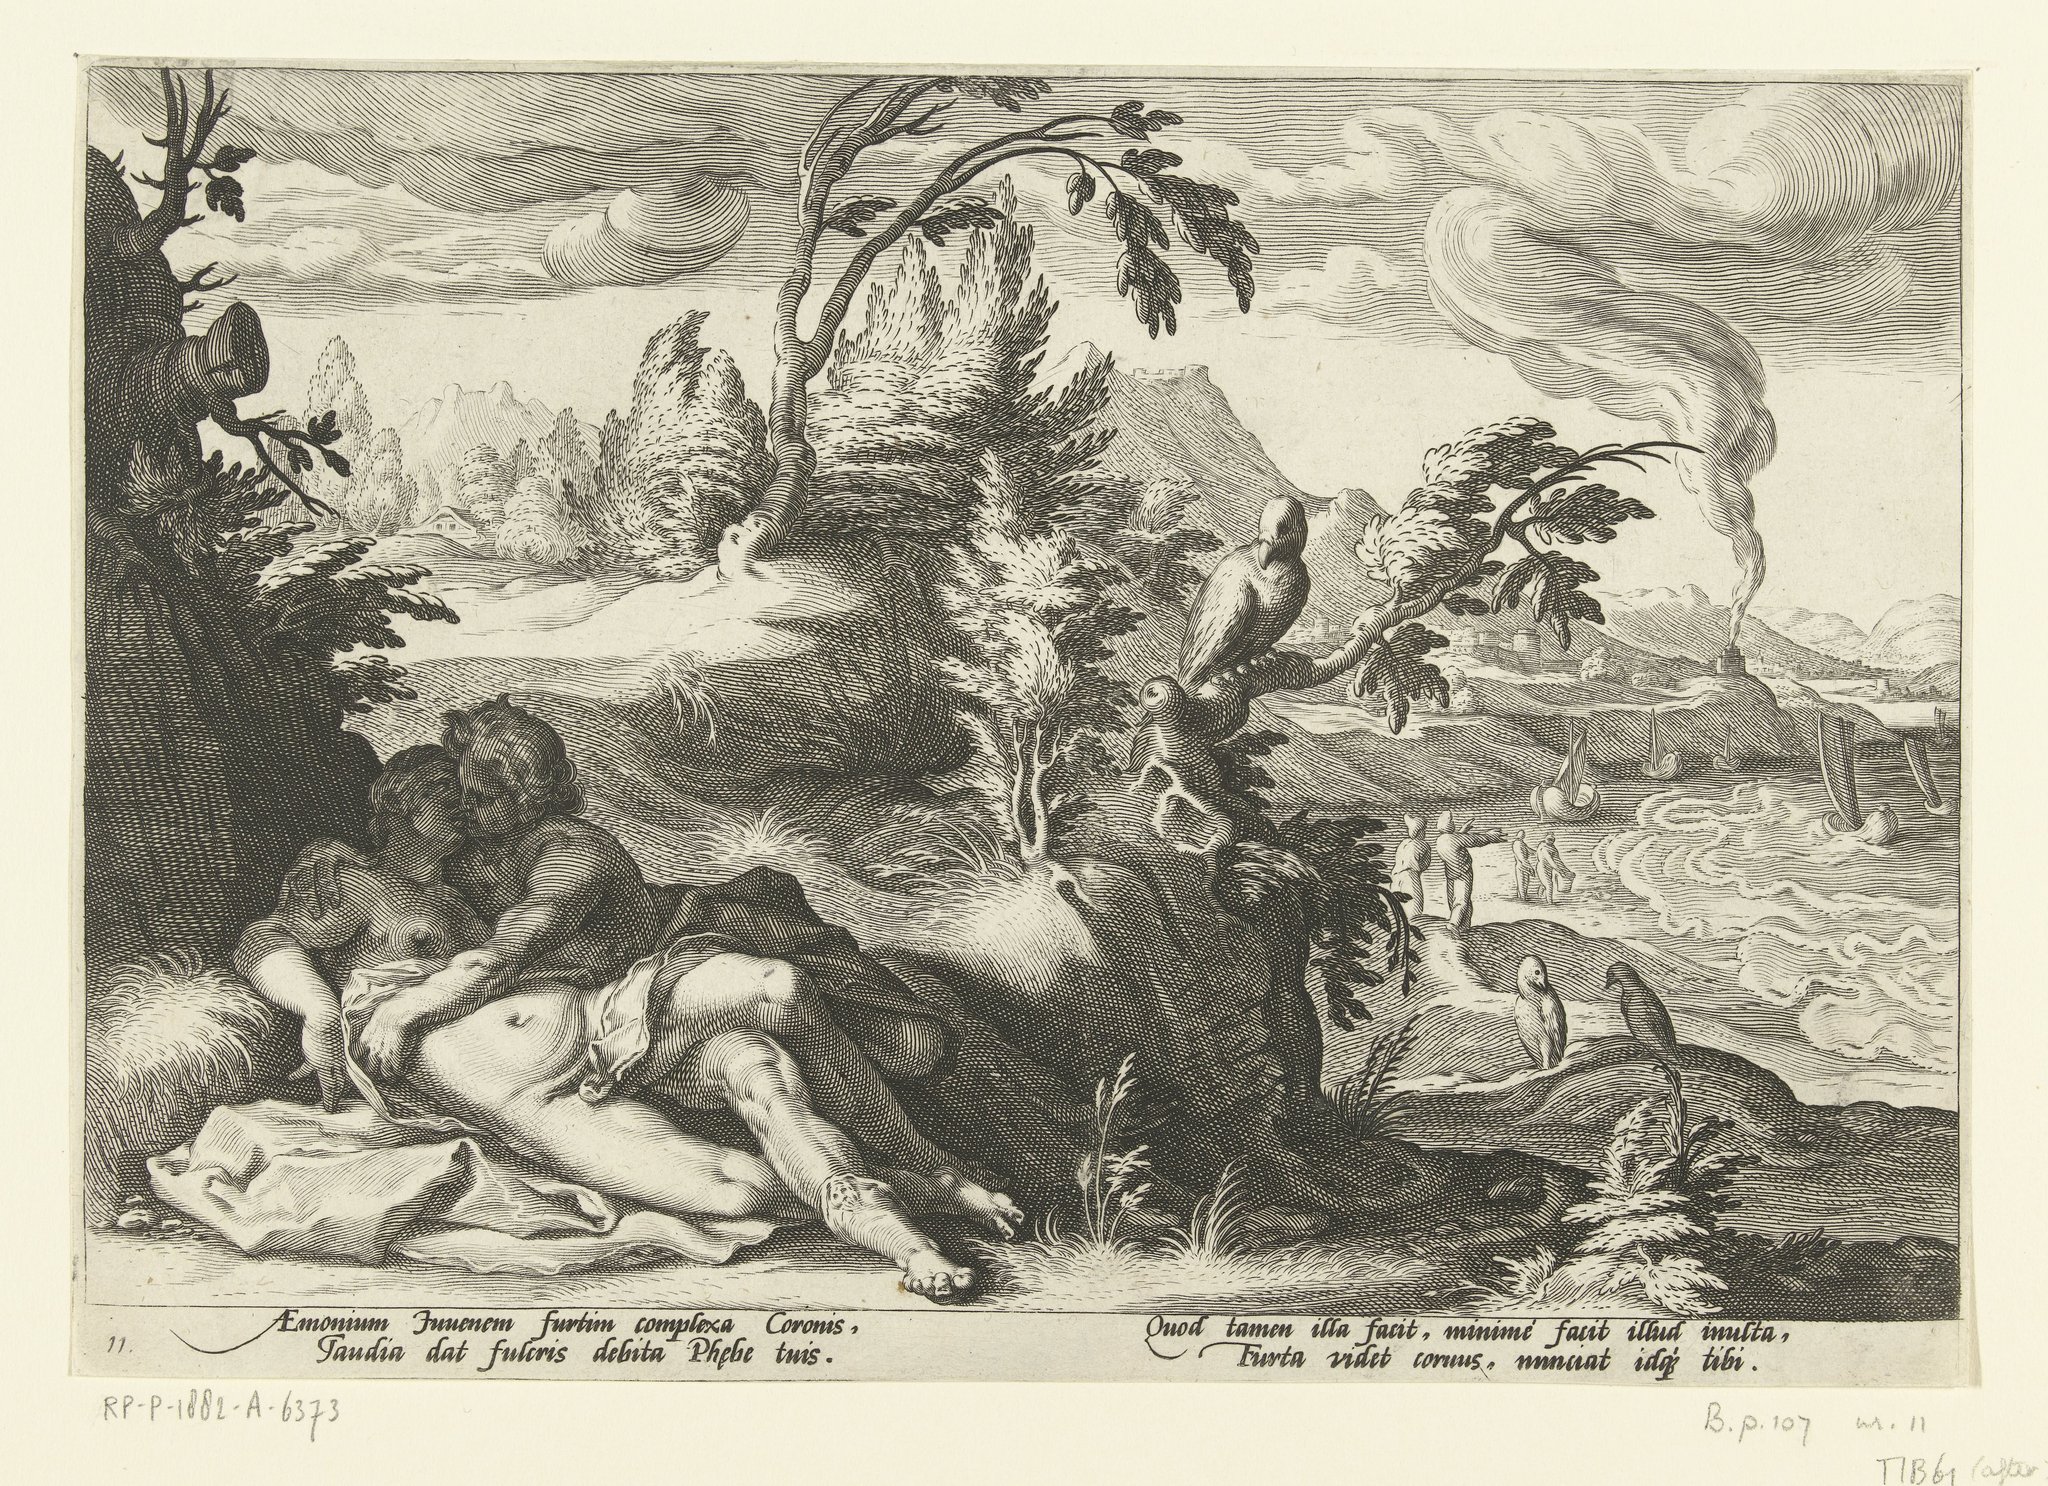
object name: print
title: Ovidius' Metamorfosen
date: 1590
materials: paper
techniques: engraving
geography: haarlem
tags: a white crow sees coronis' infidelity and tells apollo about it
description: De raaf Corvus betrapt Coronis, geliefde van Apollo, op ontrouw. Als hij dit aan de god wil melden, wordt hij voor zijn plan gewaarschuwd door de kraai Cornix. Onder de voorstelling twee keer twee regels Latijnse tekst. Deze prent is onderdeel van een serie van 52 prenten die verhalen uit Ovidius' Metamorfosen verbeelden. Deze serie valt uiteen in drie genummerde reeksen: twee van 20 prenten en één van 12 prenten. Deze prent behoort tot de tweede reeks.